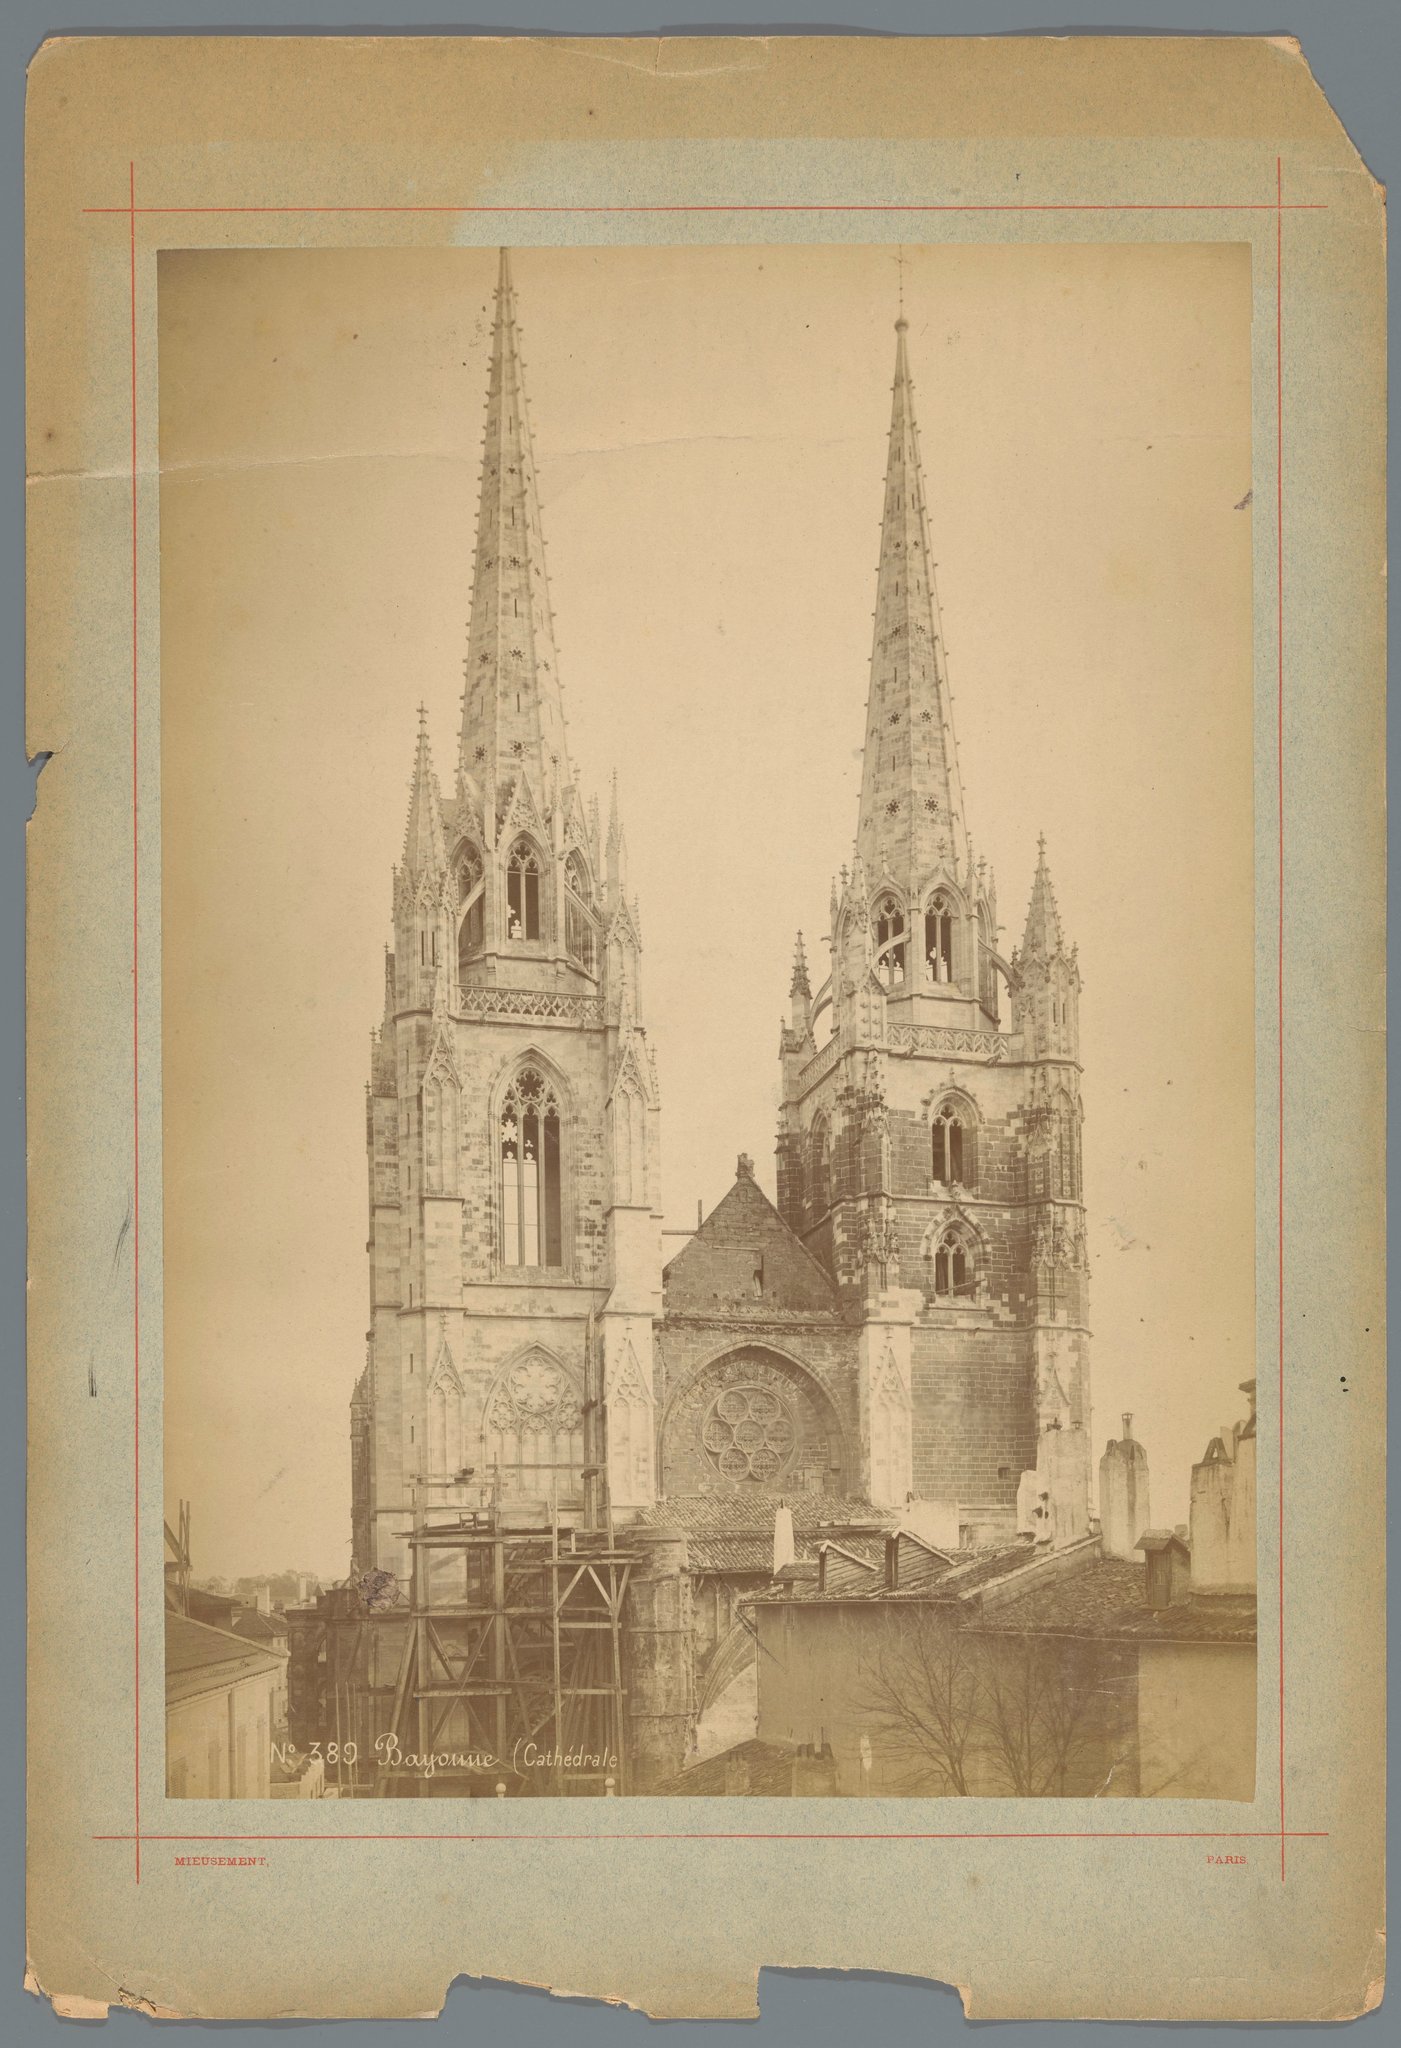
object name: photograph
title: Gezicht op de torens van de Kathedraal van Bayonne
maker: séraphin-médéric mieusement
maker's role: fotograaf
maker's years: 1840-1905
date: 1875-1900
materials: cardboard, photographic support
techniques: albumen print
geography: bayonne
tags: tower, clock tower ~ monumental adornment, church (exterior), building of church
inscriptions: collector's mark: Lugt 3937, name: ‘Monsters worden door de Representant J. A. G. de Leur den Haag op franco aanvrage verzonden’, number: ‘No. 389’